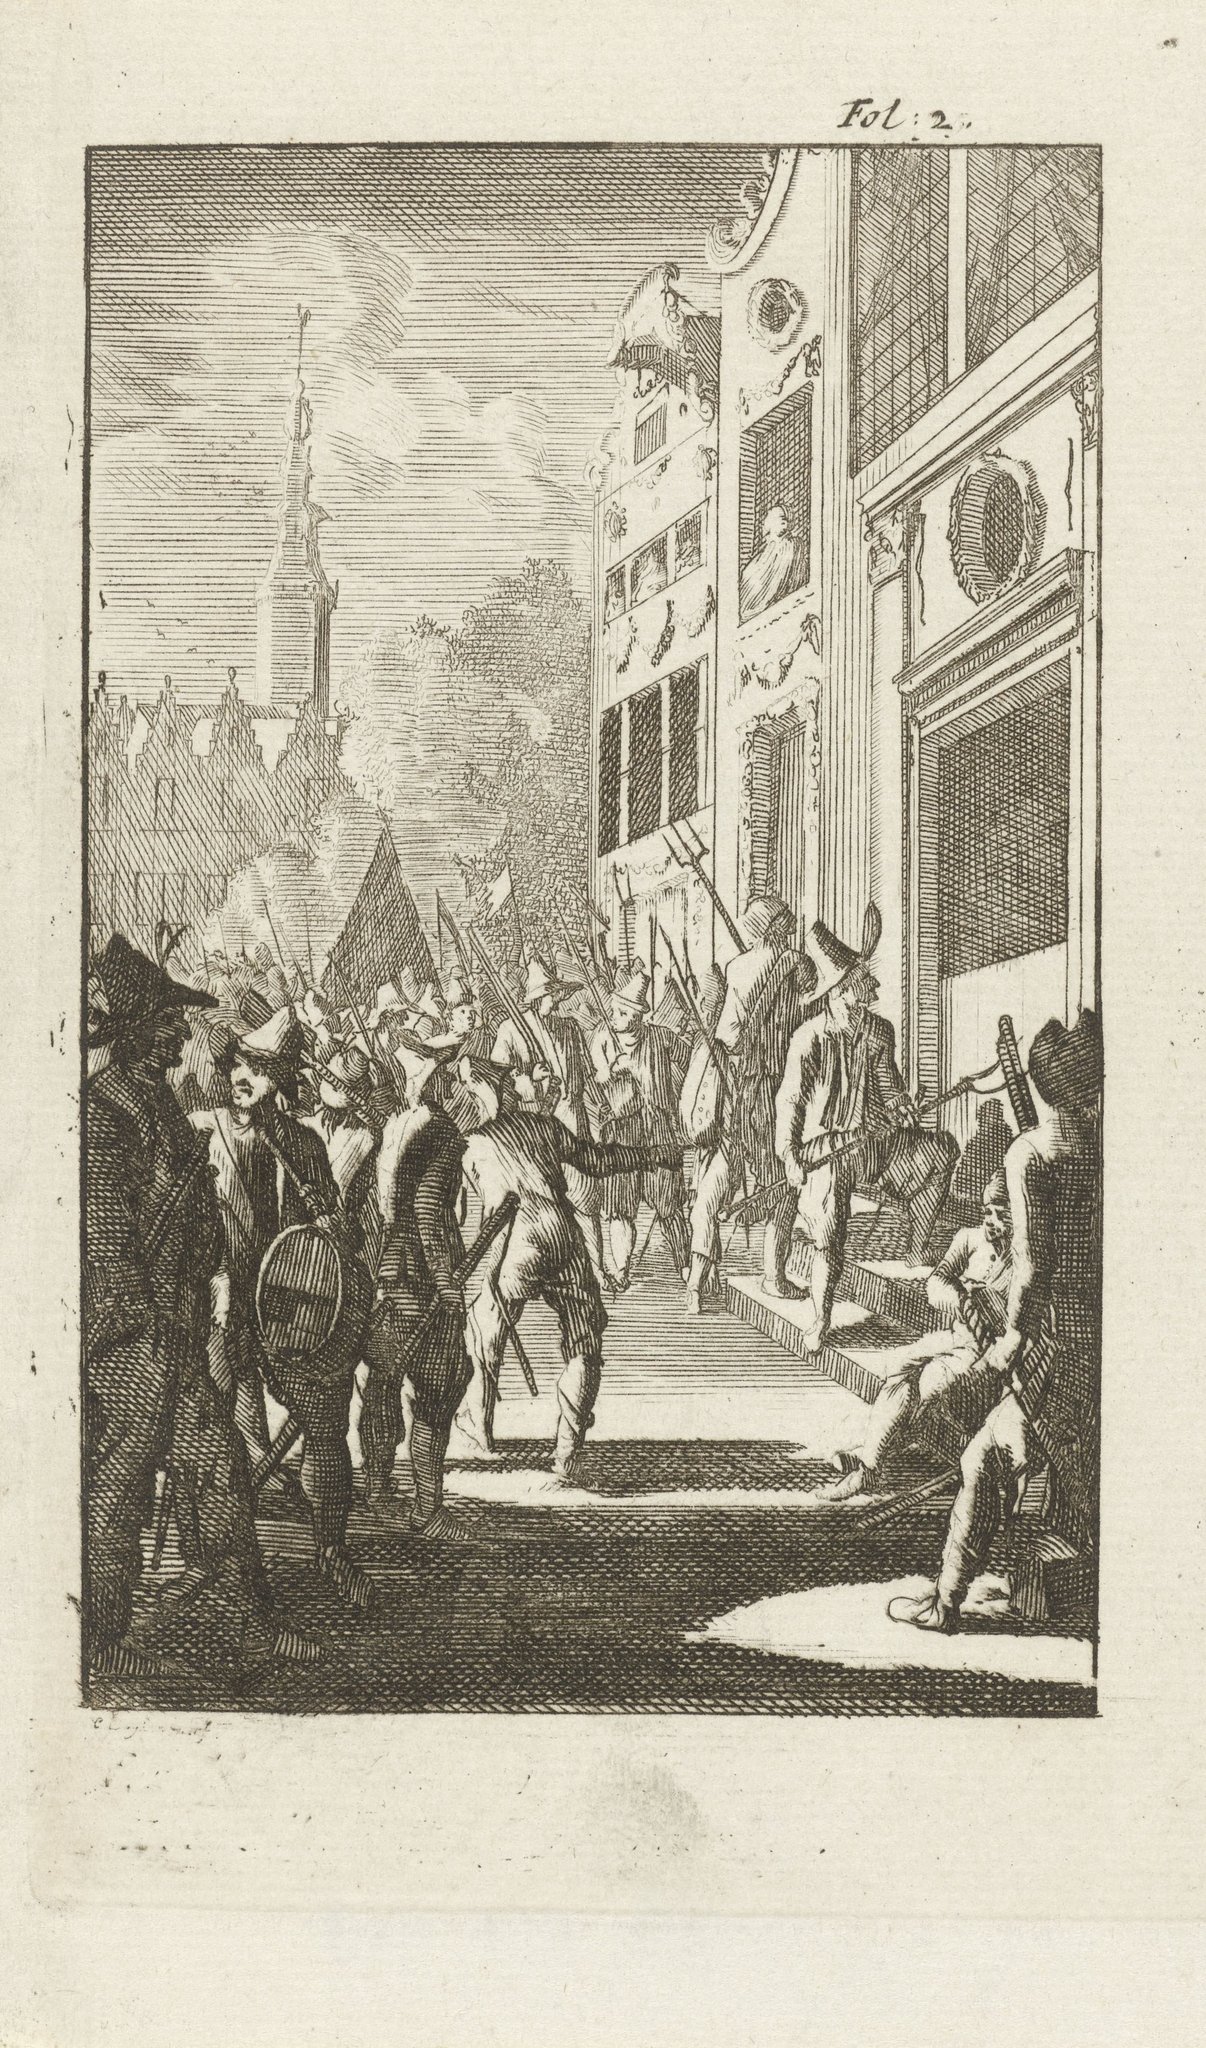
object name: book illustration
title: Aanval op het huis van burgemeester Van den Brande door opstandige boeren, 1672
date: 1692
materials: paper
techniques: etching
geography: leiden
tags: mayor, street-fights, riots, middelburg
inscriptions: collector's mark: Lugt 2228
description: Illustratie uit: Luyken, Casper. Kort dog zakelyk verhaal van alle de plunderingen en verwoestingen van de huizen en goederen der pagters in de provintien van Groningen, Vriesland en Utrecht. Leiden: Wed. Jan van der Deyster, 1748. Eerdere staat gebruikt in: Beronicius, Petrus Johannes. Boeren- en overheidsstrĳd. Amsterdam: Jan Claesz ten Hoorn, 1692.